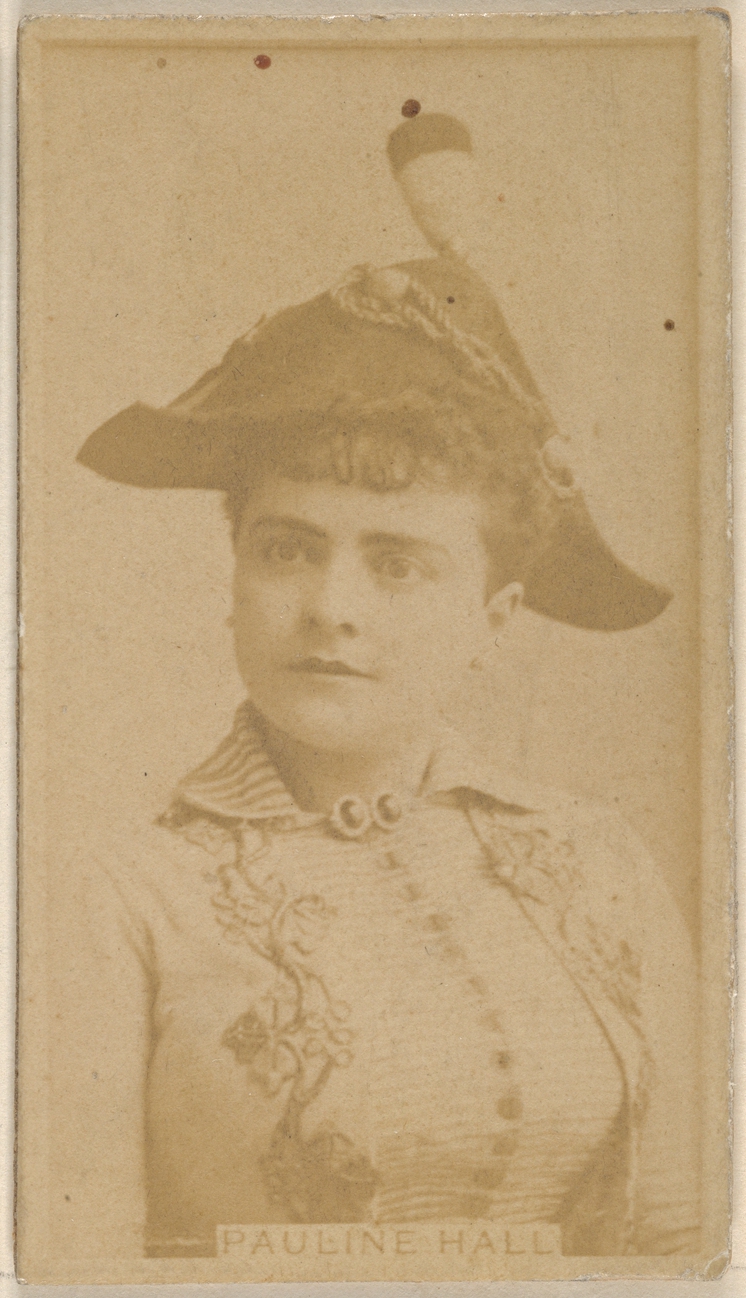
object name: photograph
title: Pauline Hall, from the Actors and Actresses series (N45, Type 8) for Virginia Brights Cigarettes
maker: allen & ginter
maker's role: publisher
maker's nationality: american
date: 1888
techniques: albumen silver print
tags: portraits,women,actresses